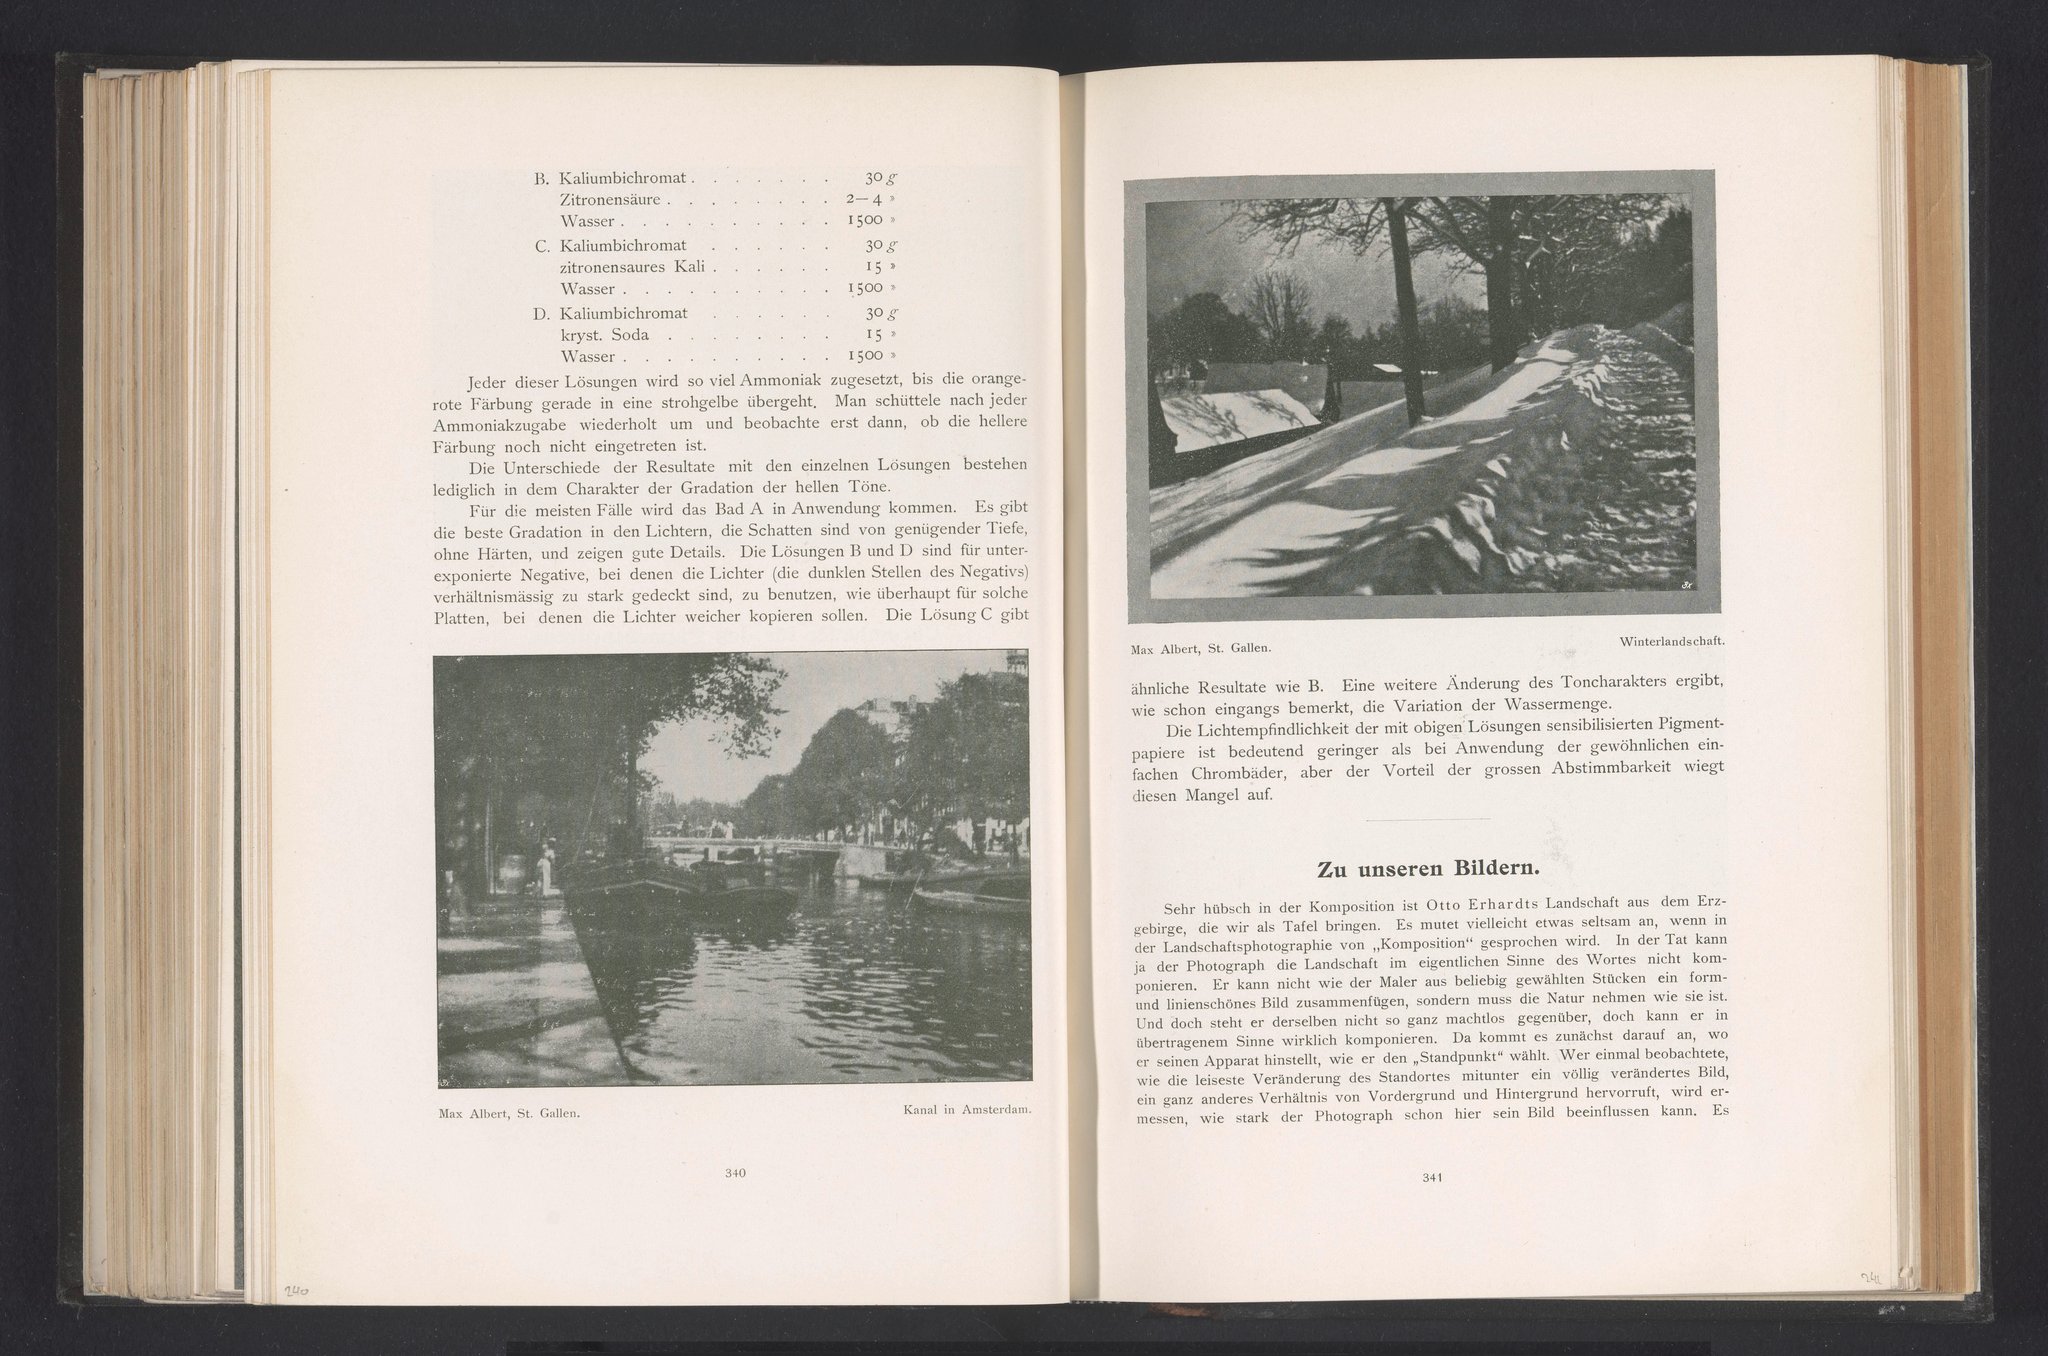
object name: page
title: Winterlandschap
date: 1898-1903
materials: paper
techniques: autotype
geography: sankt gallen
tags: landscapes, snow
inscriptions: monogram: ‘BX’